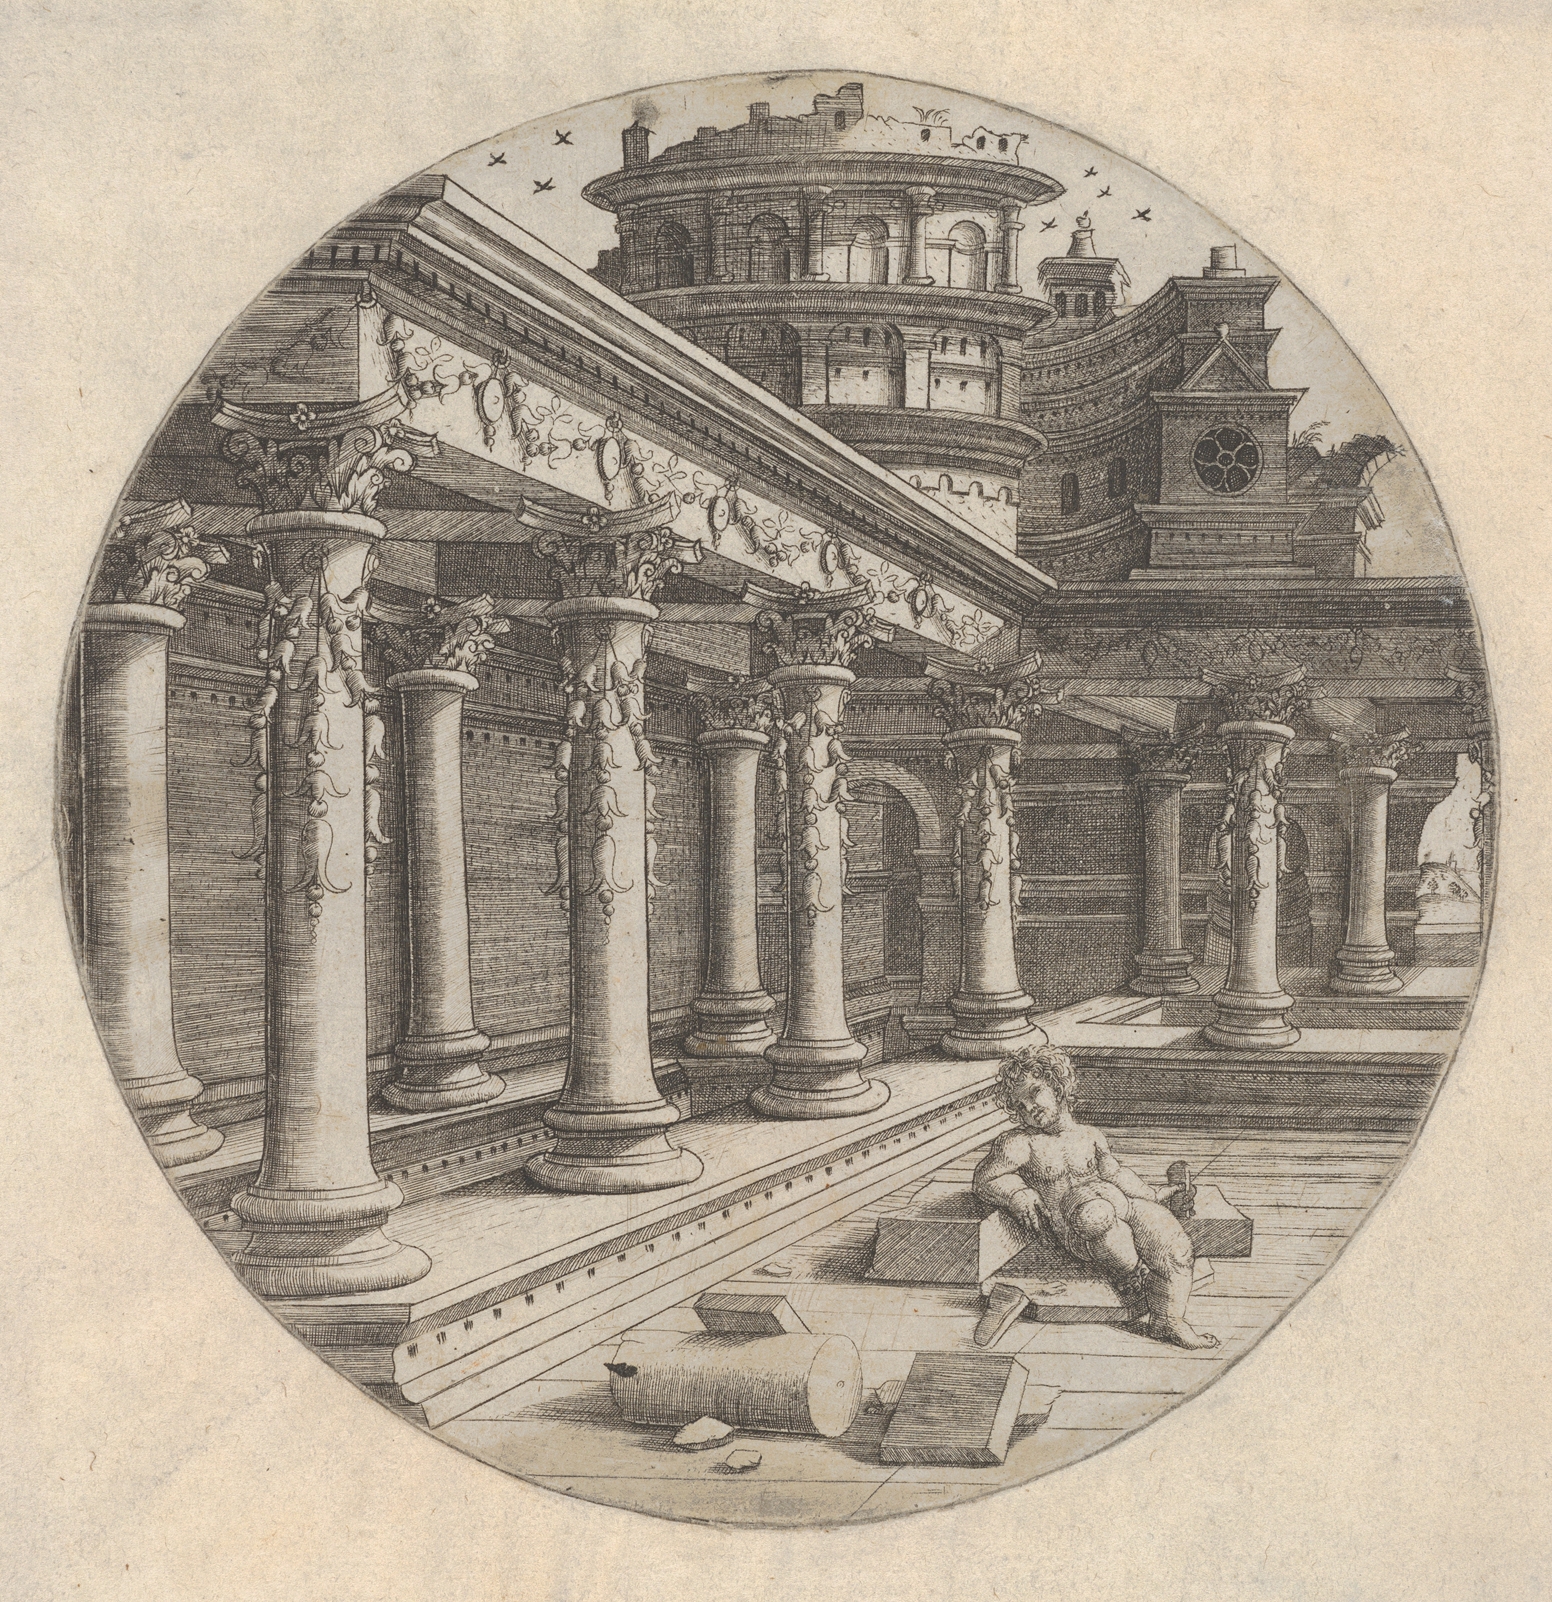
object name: print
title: L'Enfant dans la Galerie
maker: jean de gourmont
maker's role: artist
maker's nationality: french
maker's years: 1506-1551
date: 1506-1526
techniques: etching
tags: architecture,columns,children